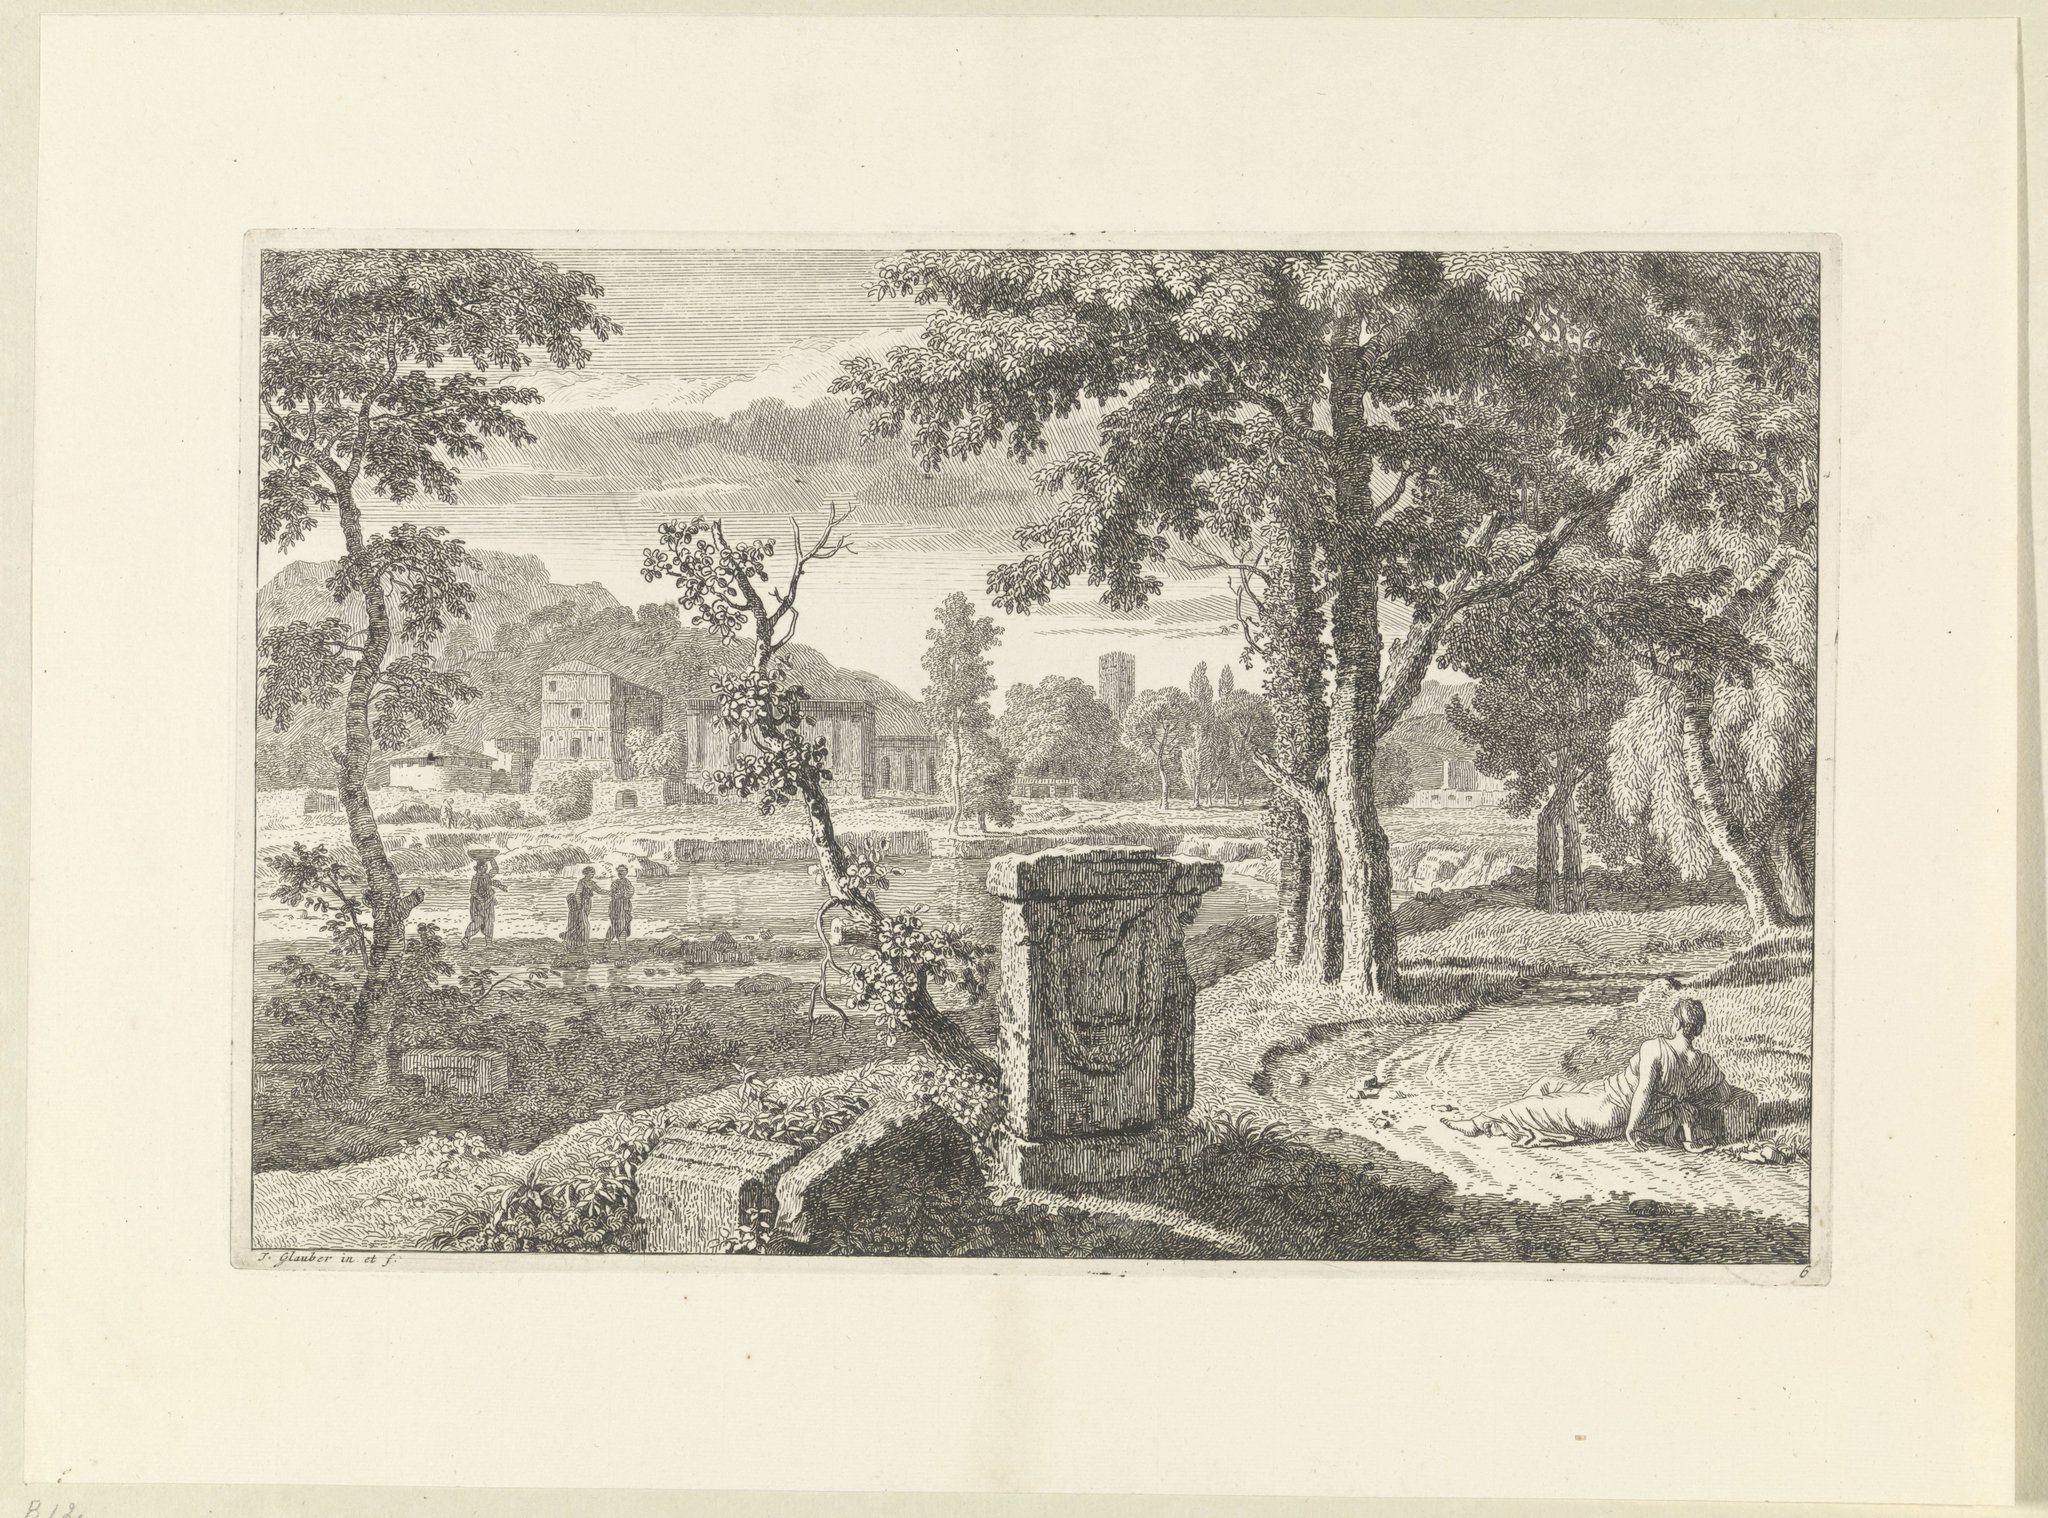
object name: print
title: Arcadisch landschap met ruïnes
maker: johannes glauber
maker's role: draughtsman, painter, print maker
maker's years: 1646-1726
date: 1656-1726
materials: paper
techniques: etching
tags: villa, landscape with ruins (+ city(-scape) with figures, staffage), pastorals, arcadian scenes, public road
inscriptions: collector's mark: Lugt 240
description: Een arcadisch landschap met ruïnes. Centraal de ruïne van een klassieke sokkel. Naast de sokkel rust een vrouw uit aan de kant van de weg. Op de achtergrond een villa en een vijver. De prent maakt deel uit van een serie met arcadische landschappen.